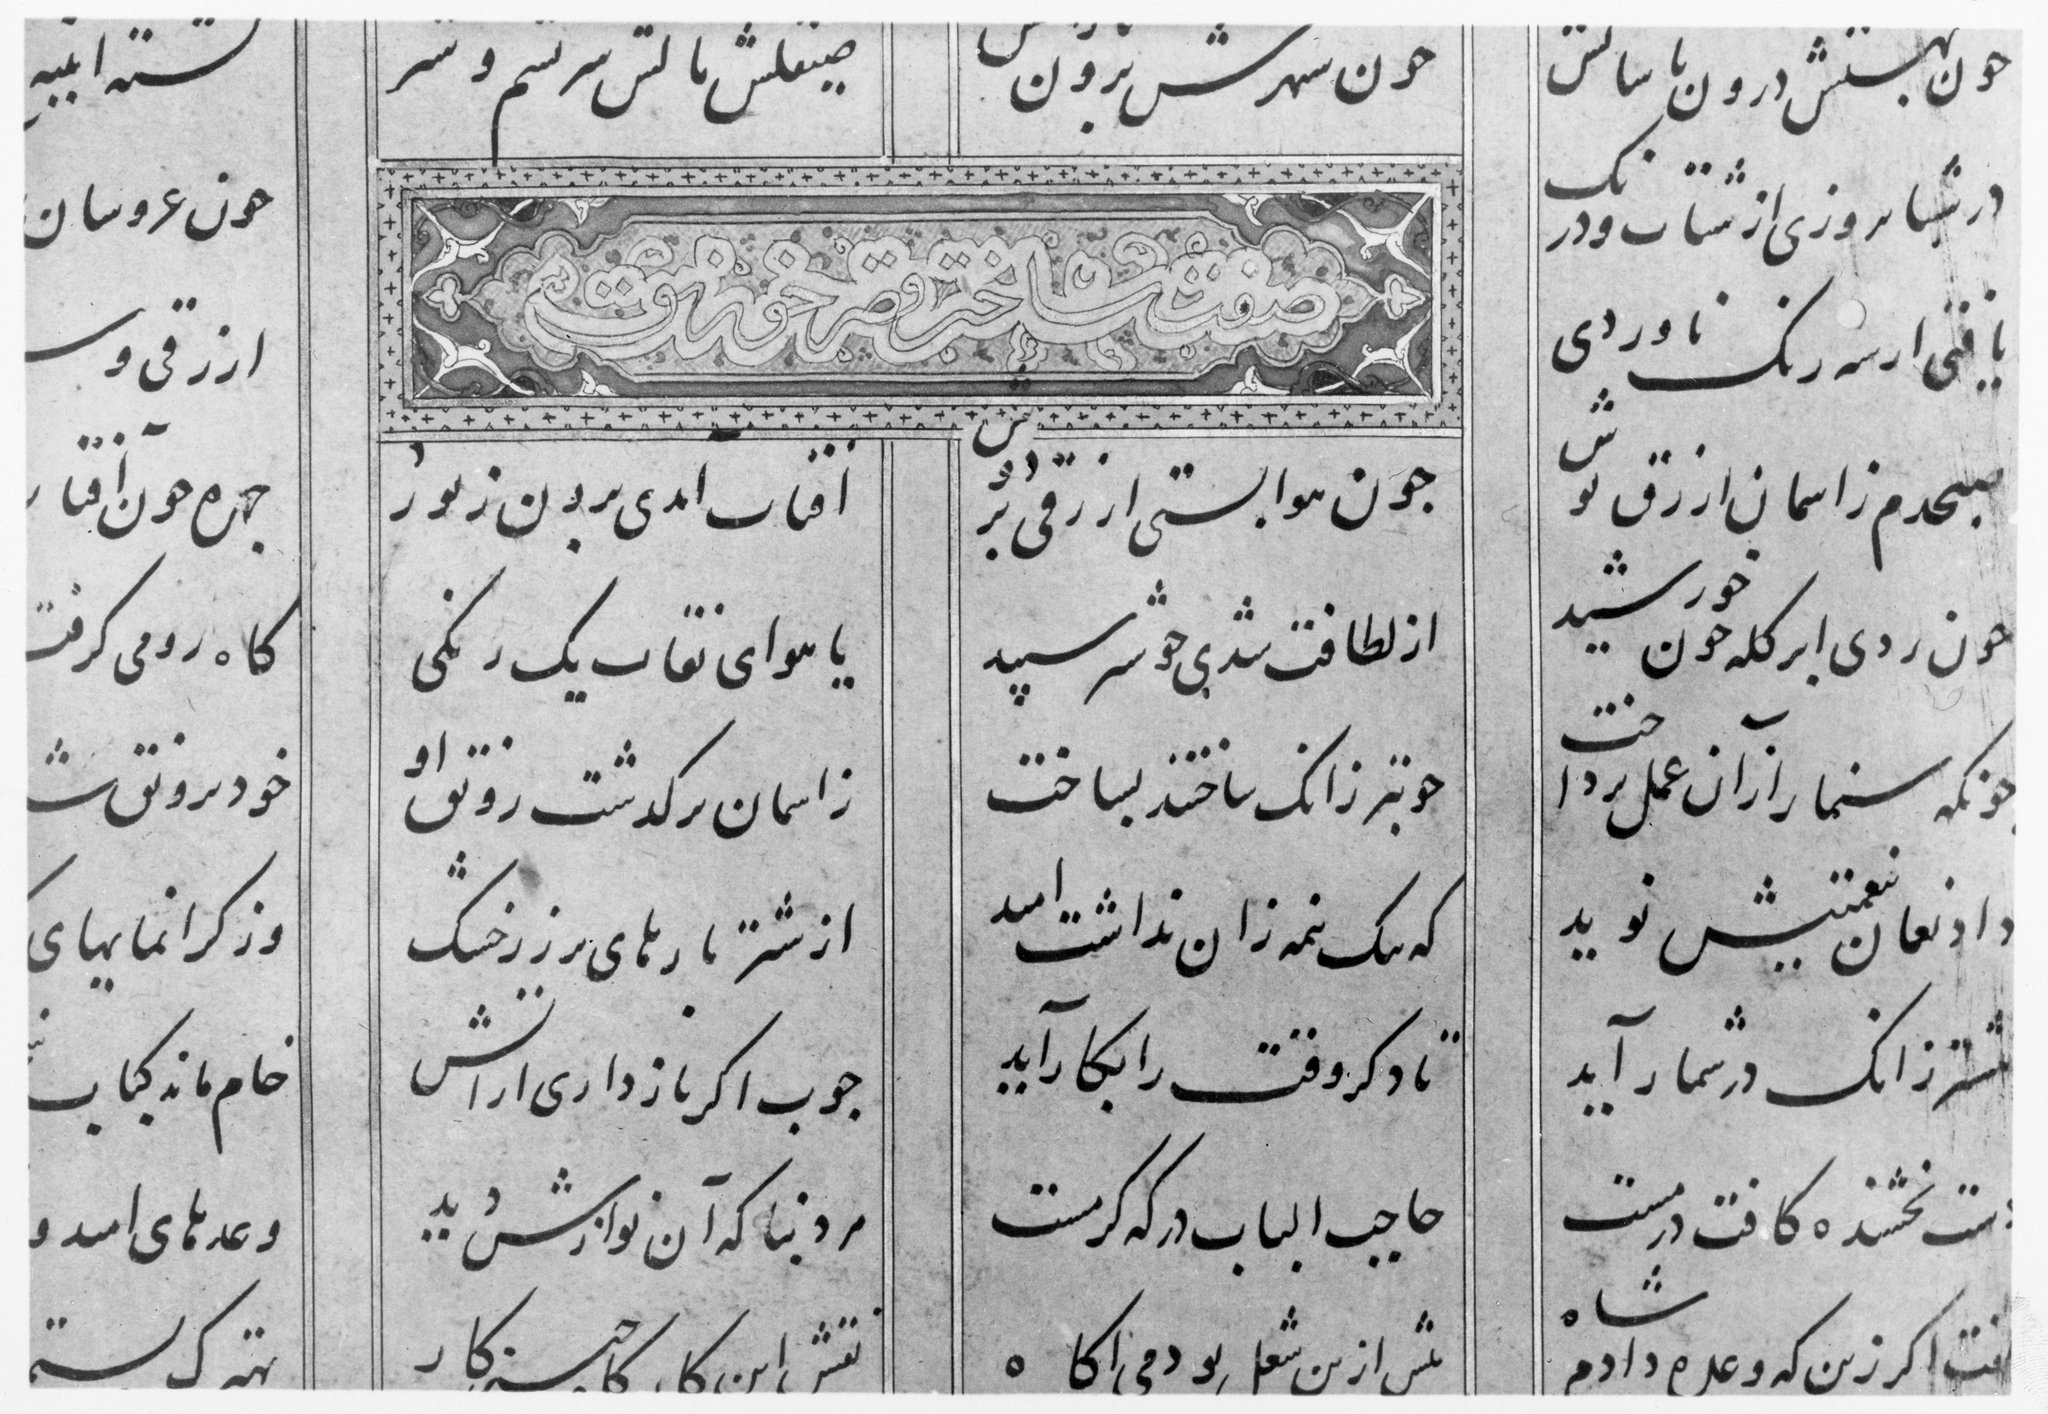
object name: illustrated manuscript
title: Haft Paikar (Seven Portraits) of the Khamsa (Quintet) of Nizami of Ganja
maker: nizami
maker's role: author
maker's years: 1141-1209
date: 1430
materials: gold, ink, lacquer, paper, watercolor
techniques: bookbinding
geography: afghanistan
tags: animals,men,hunting,horses